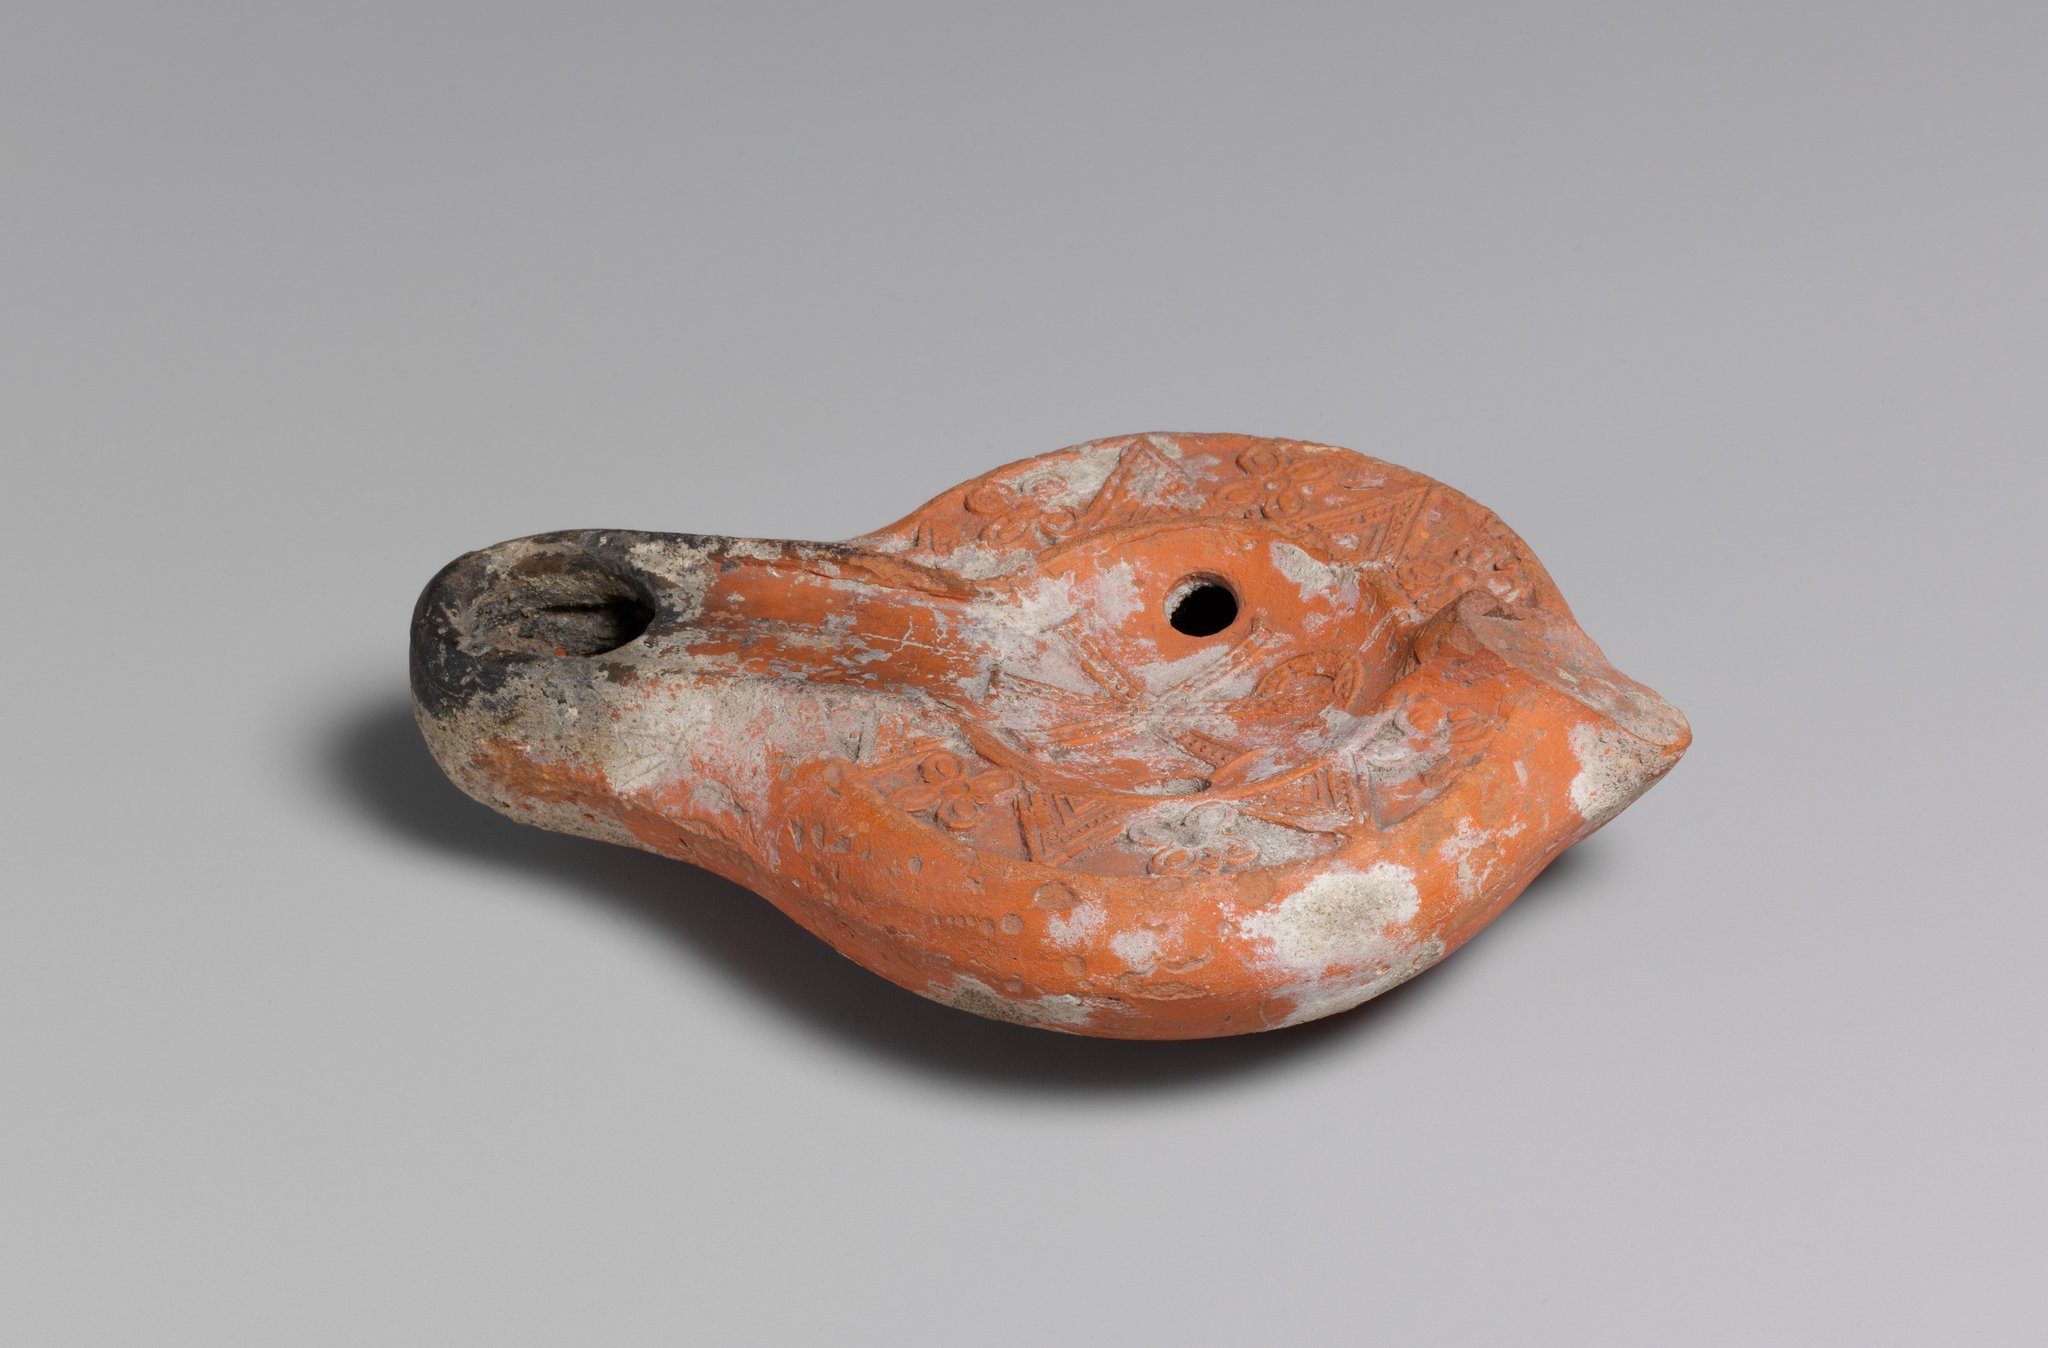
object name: lamp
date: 401-600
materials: earthenware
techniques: molding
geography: egypt